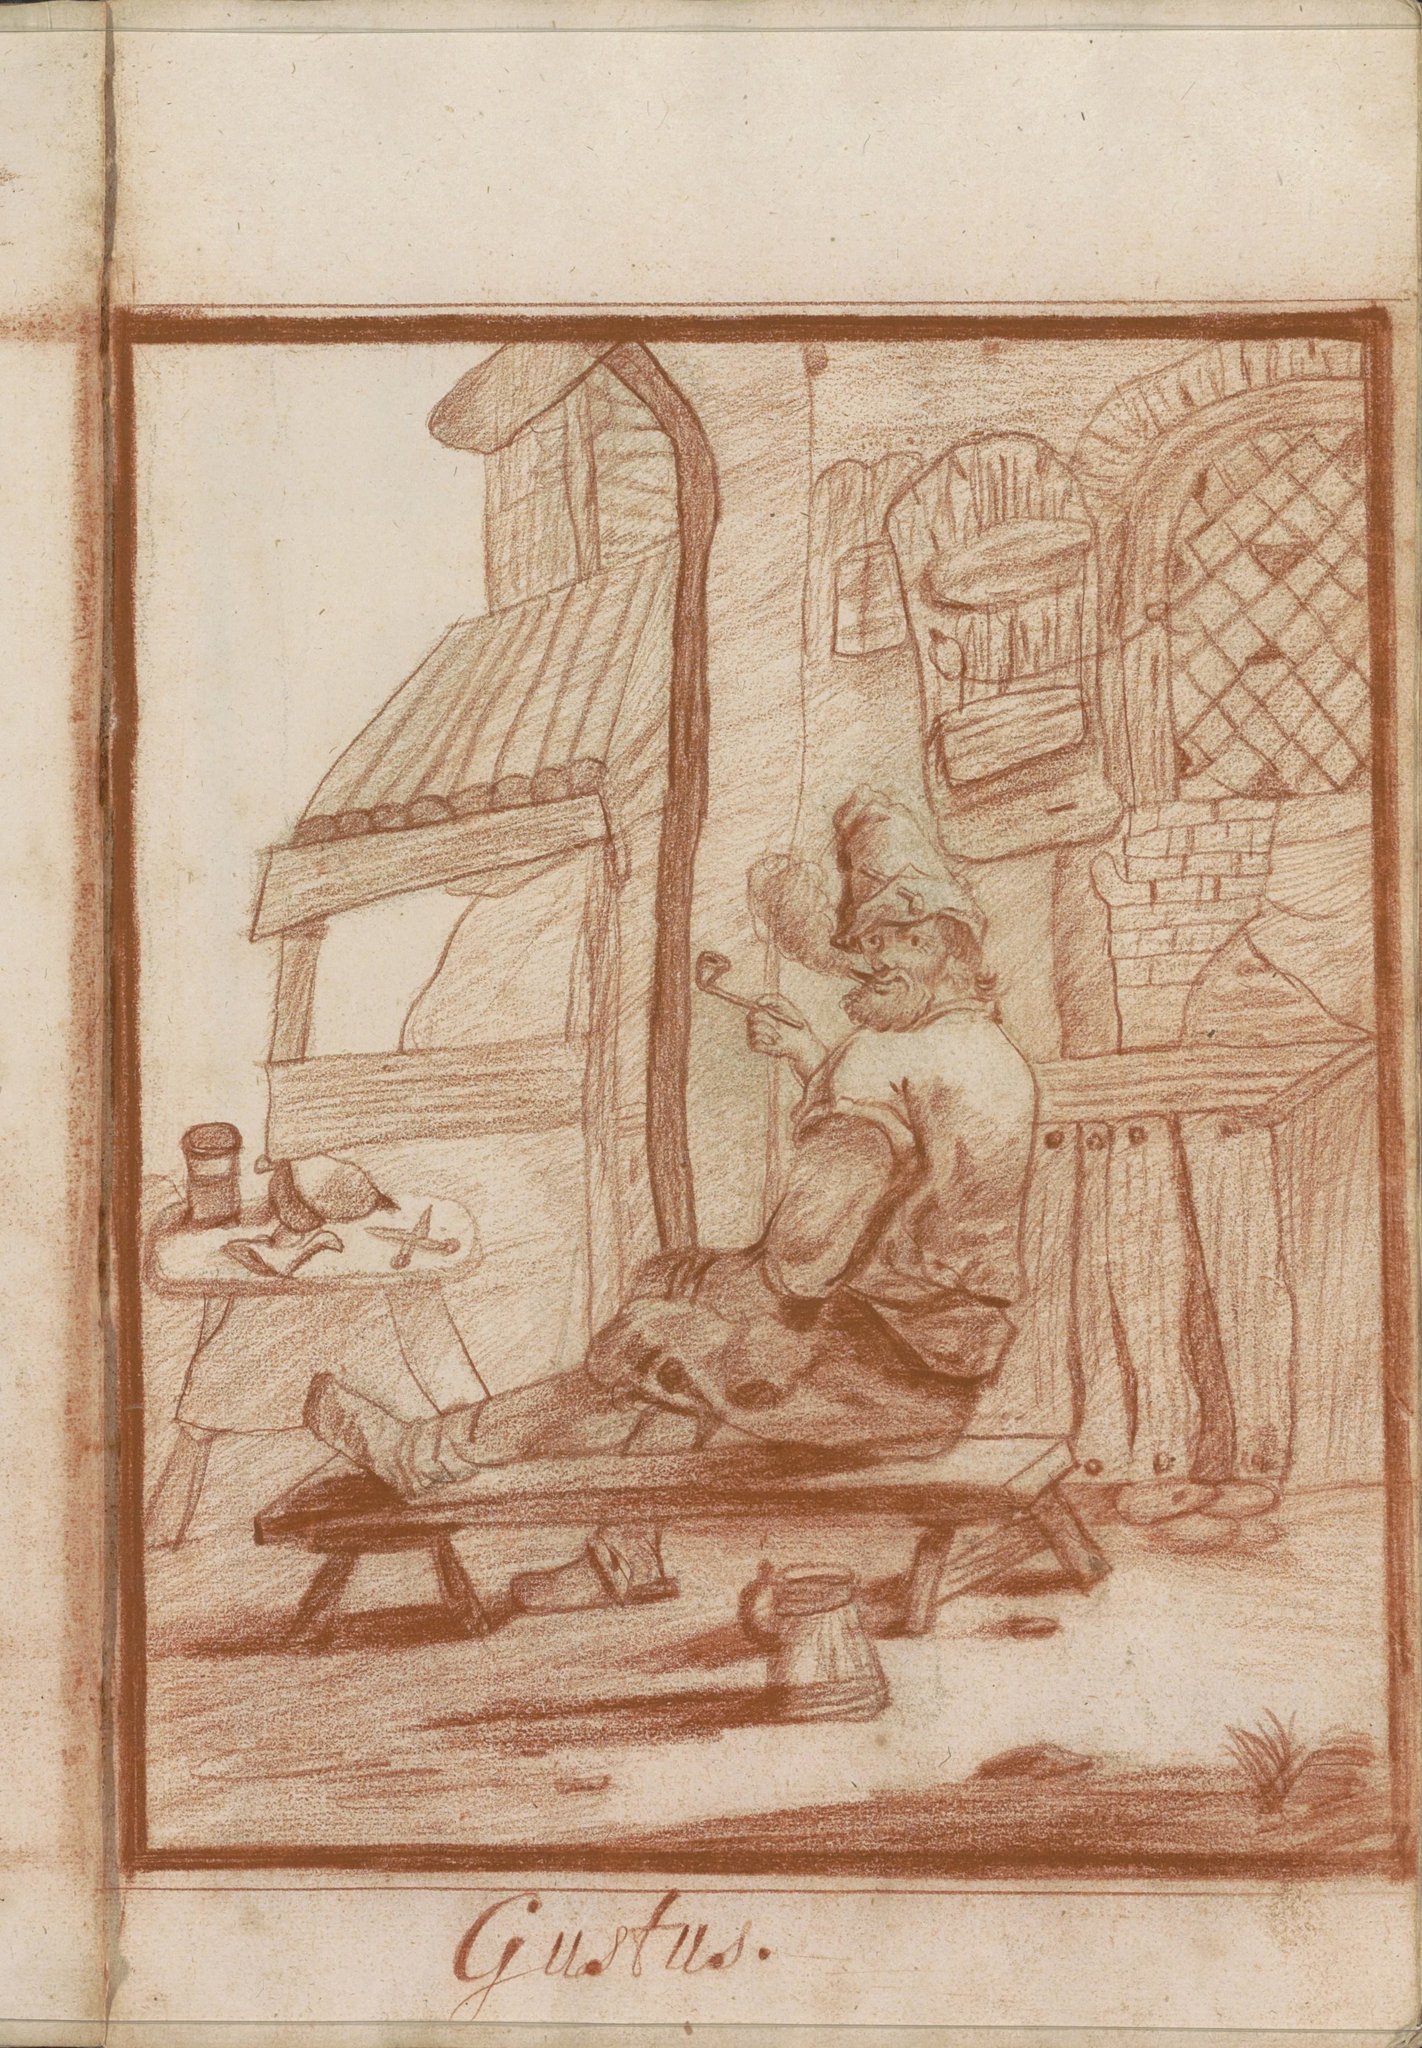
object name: sketchbook leaf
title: Smaak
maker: hendrick van beaumont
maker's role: draughtsman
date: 1696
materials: chalk, paper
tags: taste, tasting (one of the five senses)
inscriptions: annotation: ‘Gustus’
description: Een man zit voor een boerenwoning op een houten bank met een pijp in zijn hand en blaast een rookwolk uit. Blad 14 recto uit een schetsboek met 91 bladen.